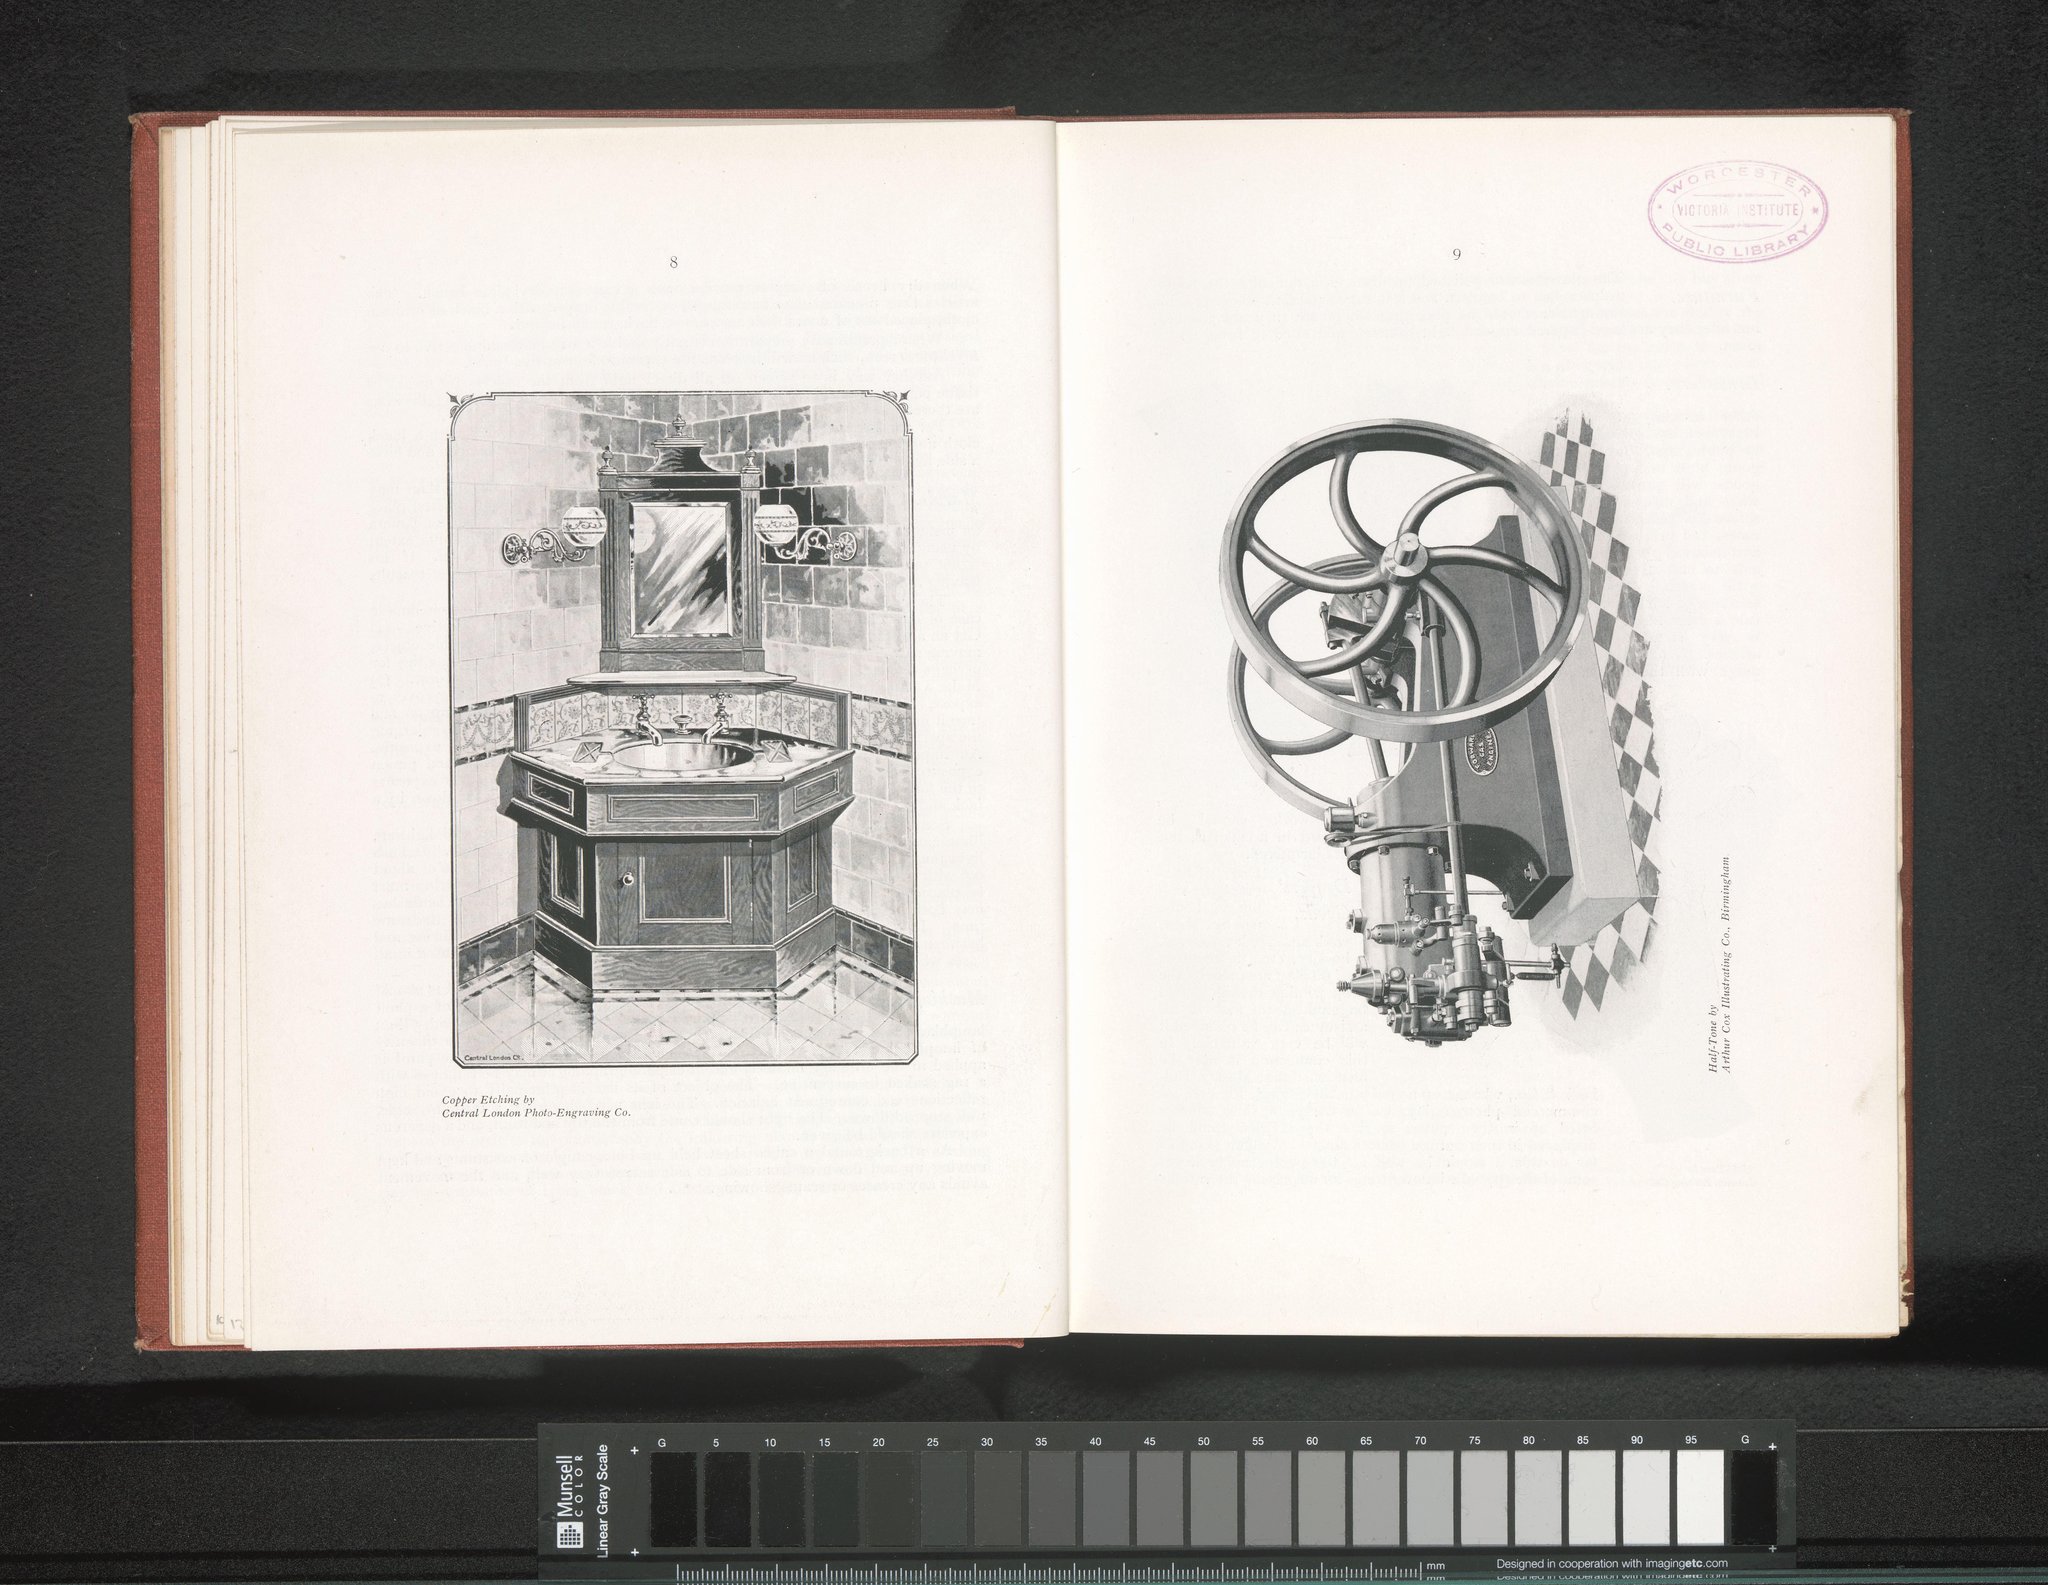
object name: reproduction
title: Reproductie van een tekening van een wastafel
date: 1895-1900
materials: paper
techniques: autotype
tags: sink, basin